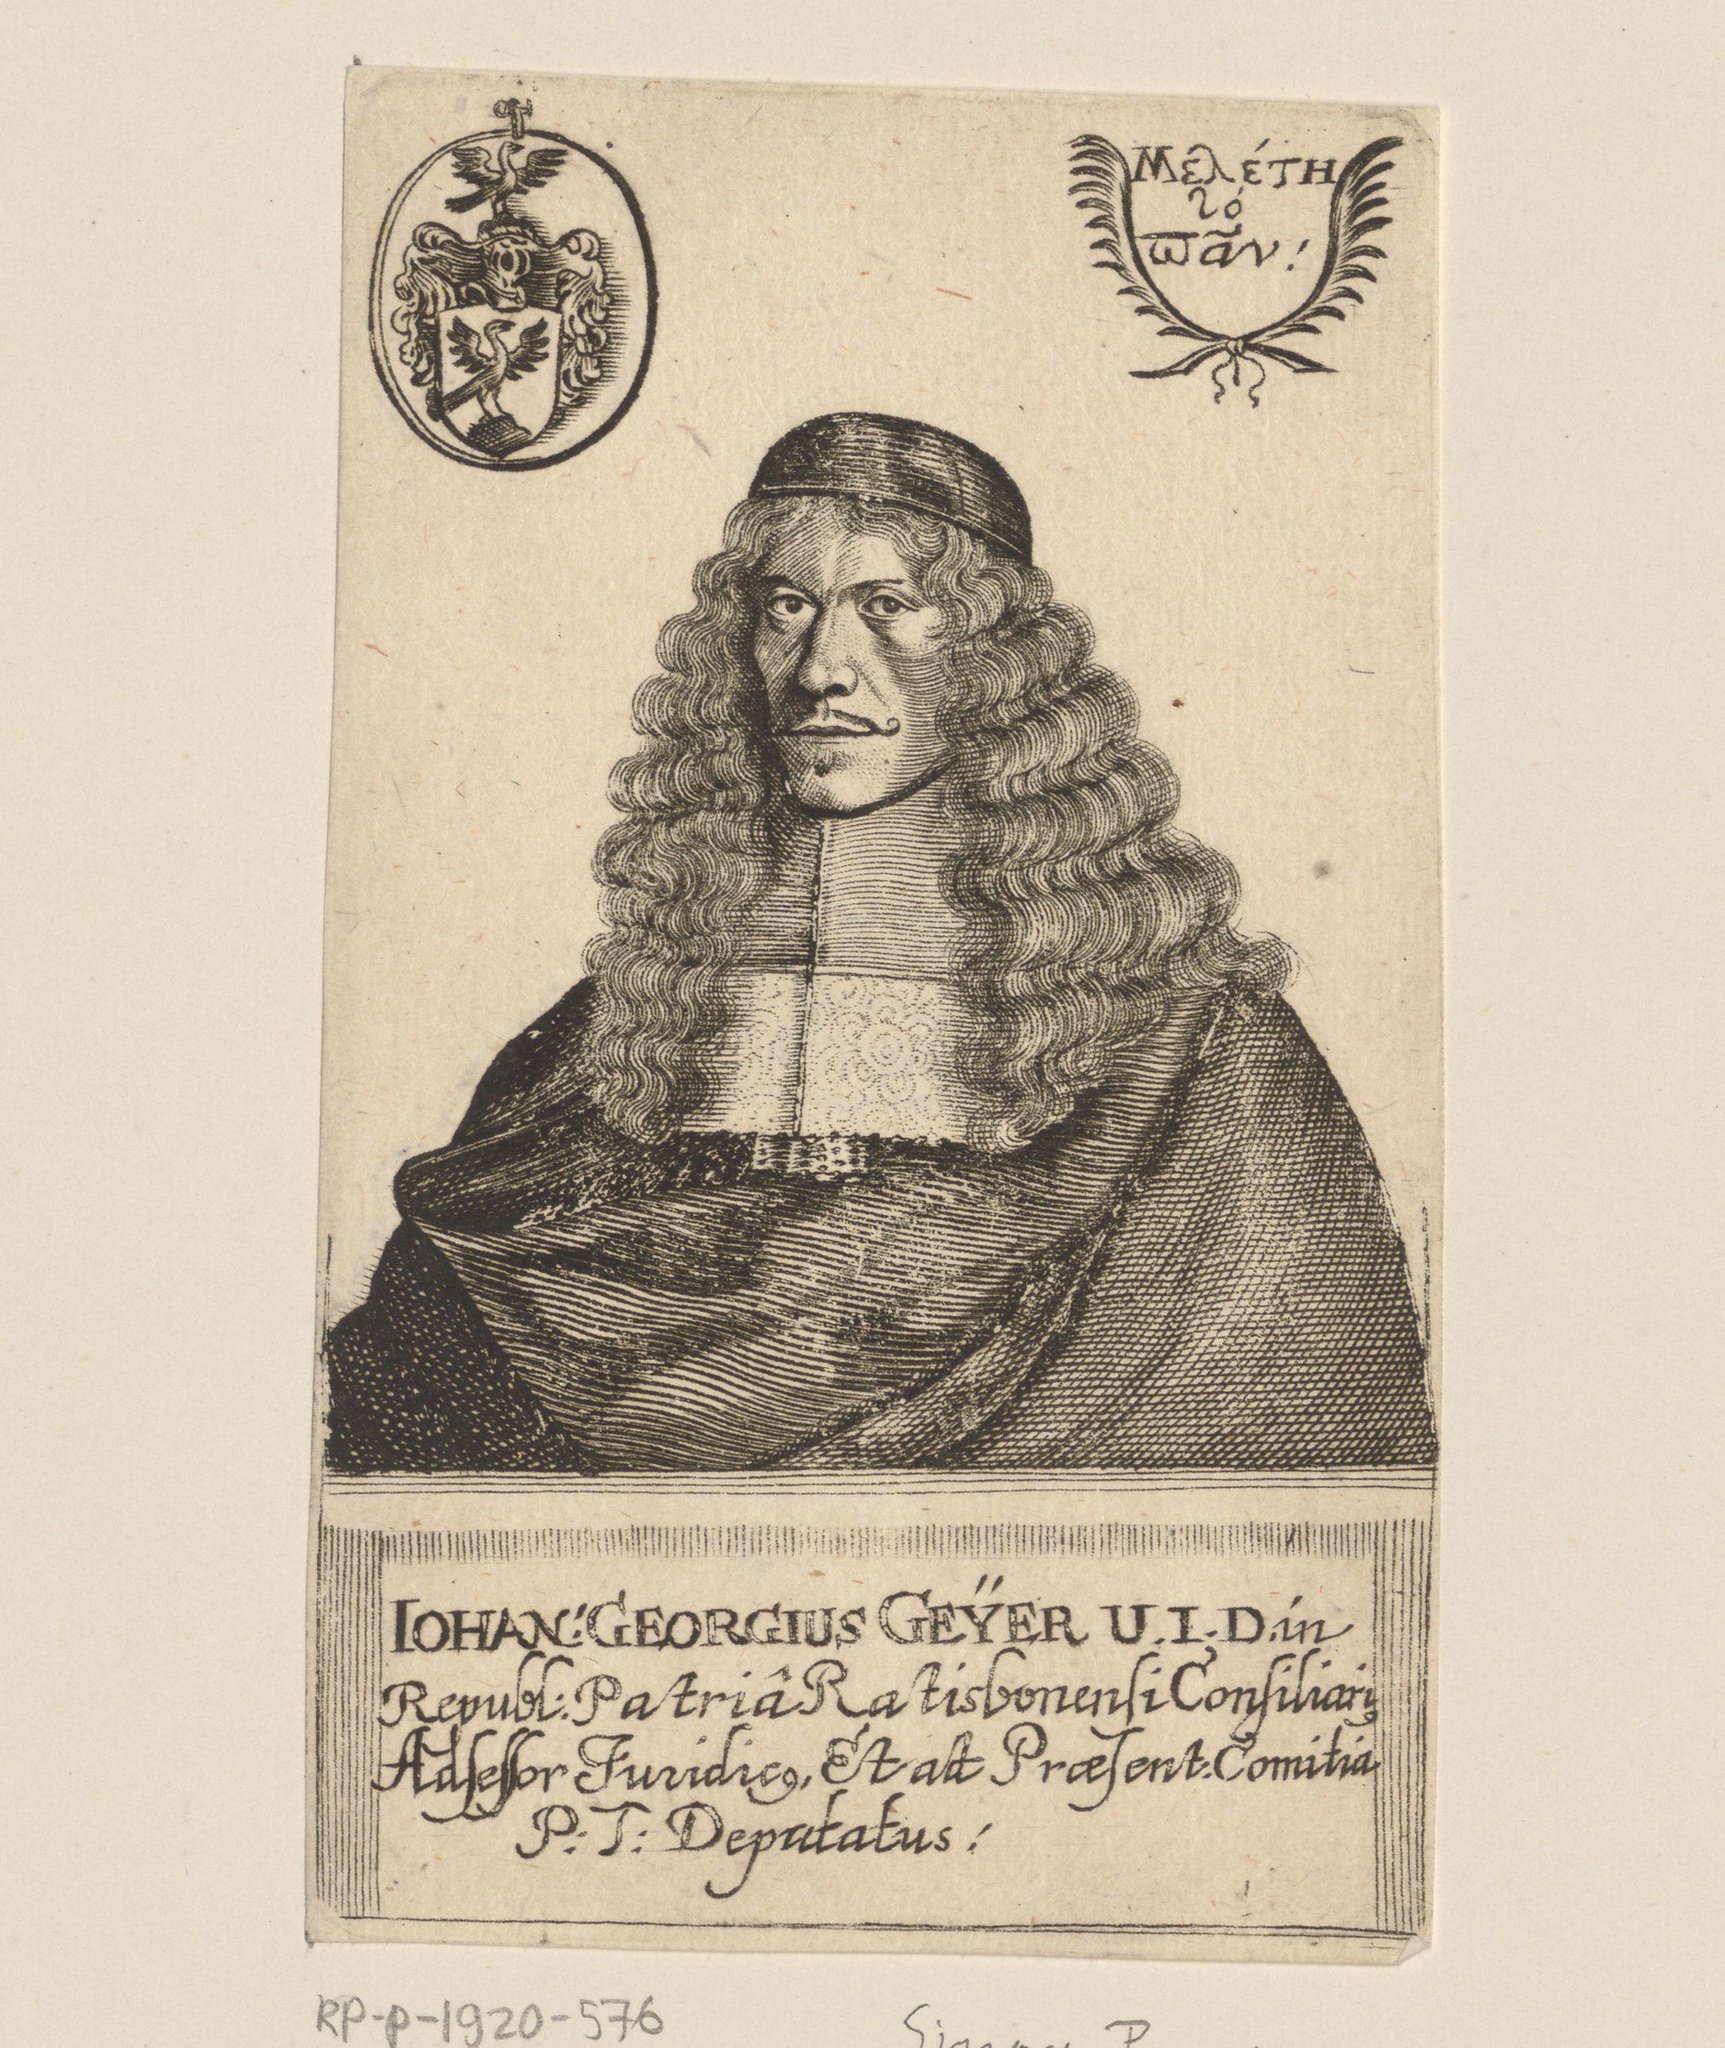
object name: print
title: Portret van Johann Georg Geier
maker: Anonymous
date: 1653-1700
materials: paper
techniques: engraving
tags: historical persons, lawyer, attorney at law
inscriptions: collector's mark: Lugt 2228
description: Tekst in het Latijn in de ondermarge en tekst in het Grieks bovenaan.